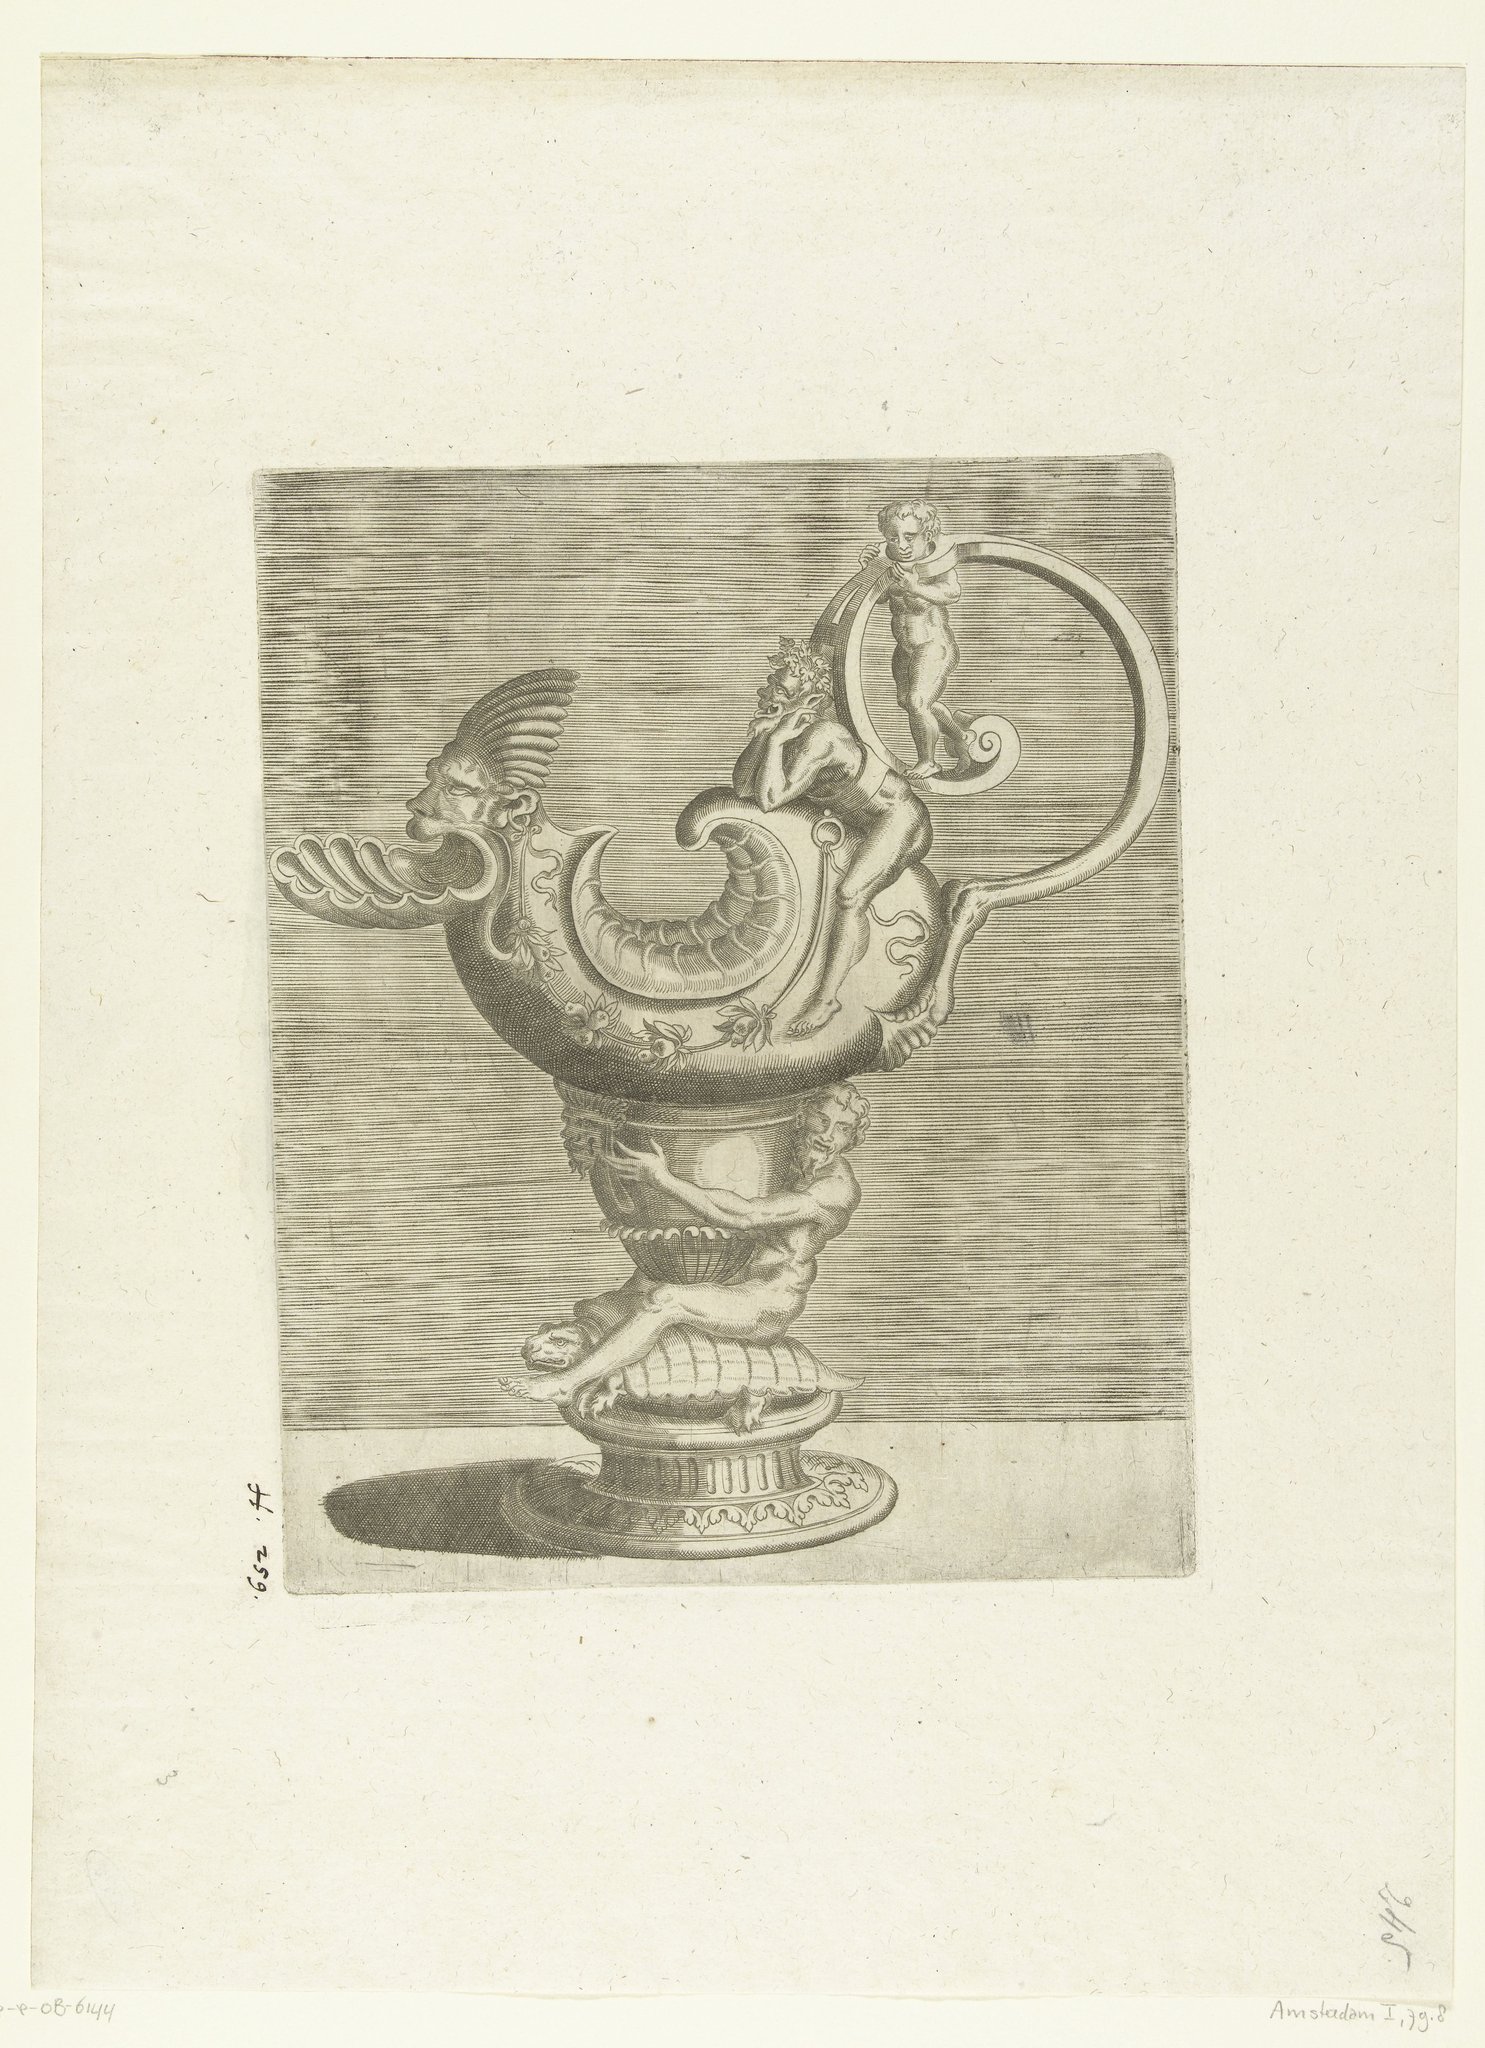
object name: ornament print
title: Vazen, kannen en schalen met grotesken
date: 1548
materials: paper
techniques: engraving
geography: netherlands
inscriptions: number: ‘H. 259’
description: Het oor van rolwerk rust op de rug van een man die op de bokaal voorovergeleund zit. In het oor staat een kind. Afkomstig uit een serie bestaande uit een titelblad en 20 bladen.